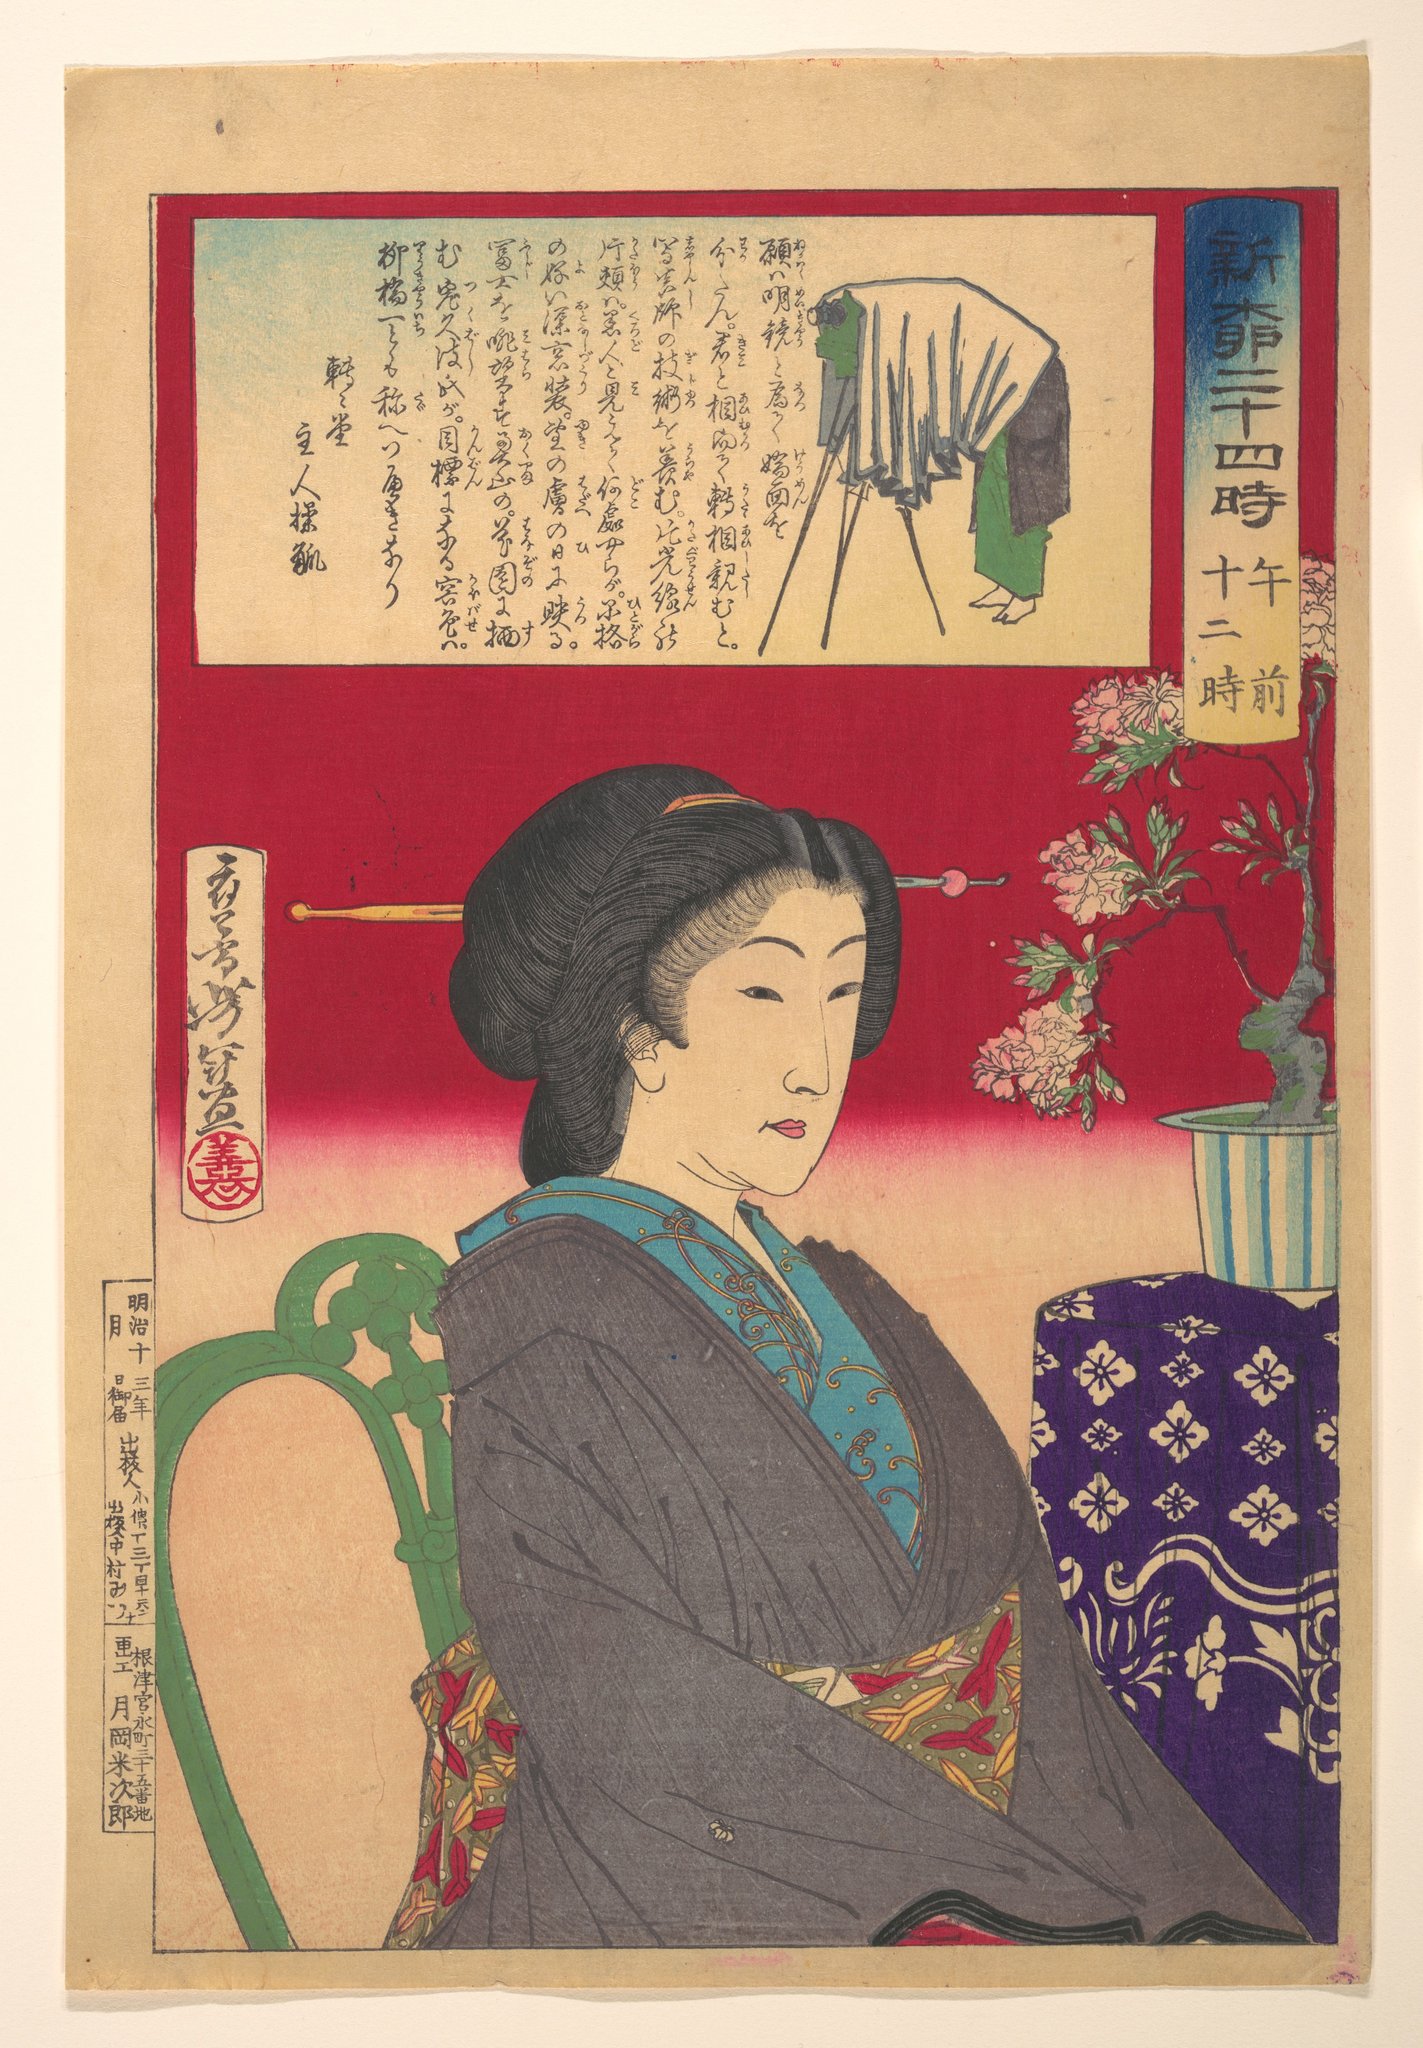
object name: print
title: Twenty-Four Hours at Shinbashi/Yanagibashi: 12 Noon. (Shinyanagi nijūyo-ji, gozen jūni-ji)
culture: japanese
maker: tsukioka yoshitoshi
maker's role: artist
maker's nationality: japanese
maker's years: 1839-1892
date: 1880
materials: ink, paper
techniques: woodblock print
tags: women,flowers,plants